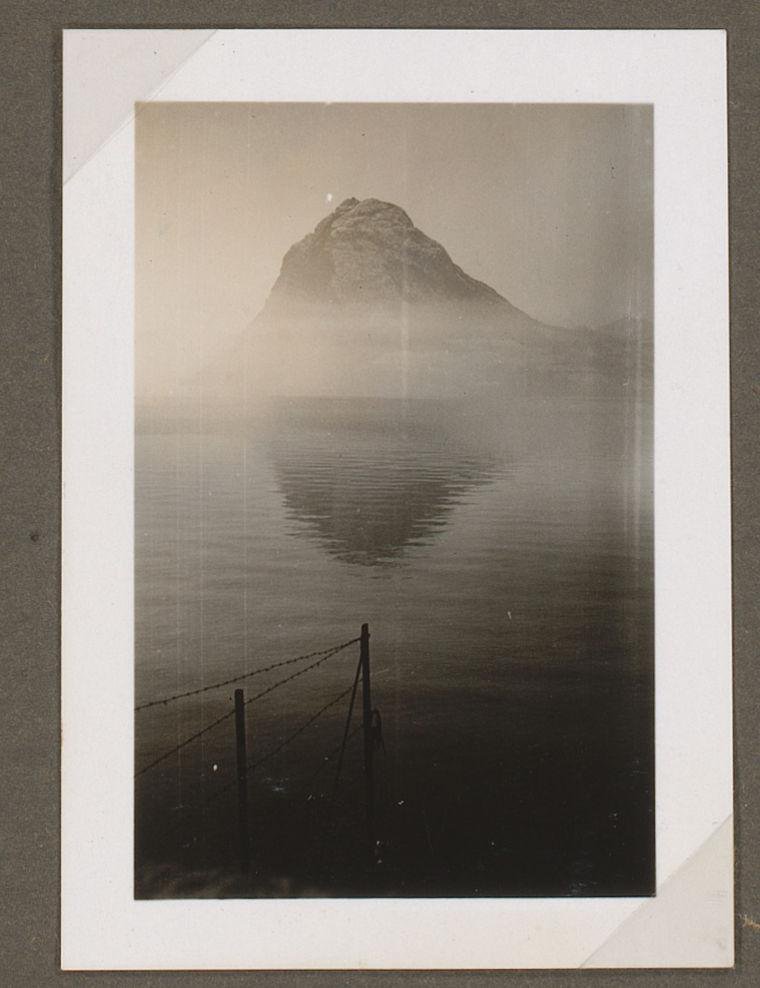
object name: photograph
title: Naar Monte Brè Salvatore vanaf Casserate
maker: Anonymous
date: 1934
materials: photographic support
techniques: gelatin silver print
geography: lake lugano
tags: mountain-top, peak, lake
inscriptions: number: ‘34’